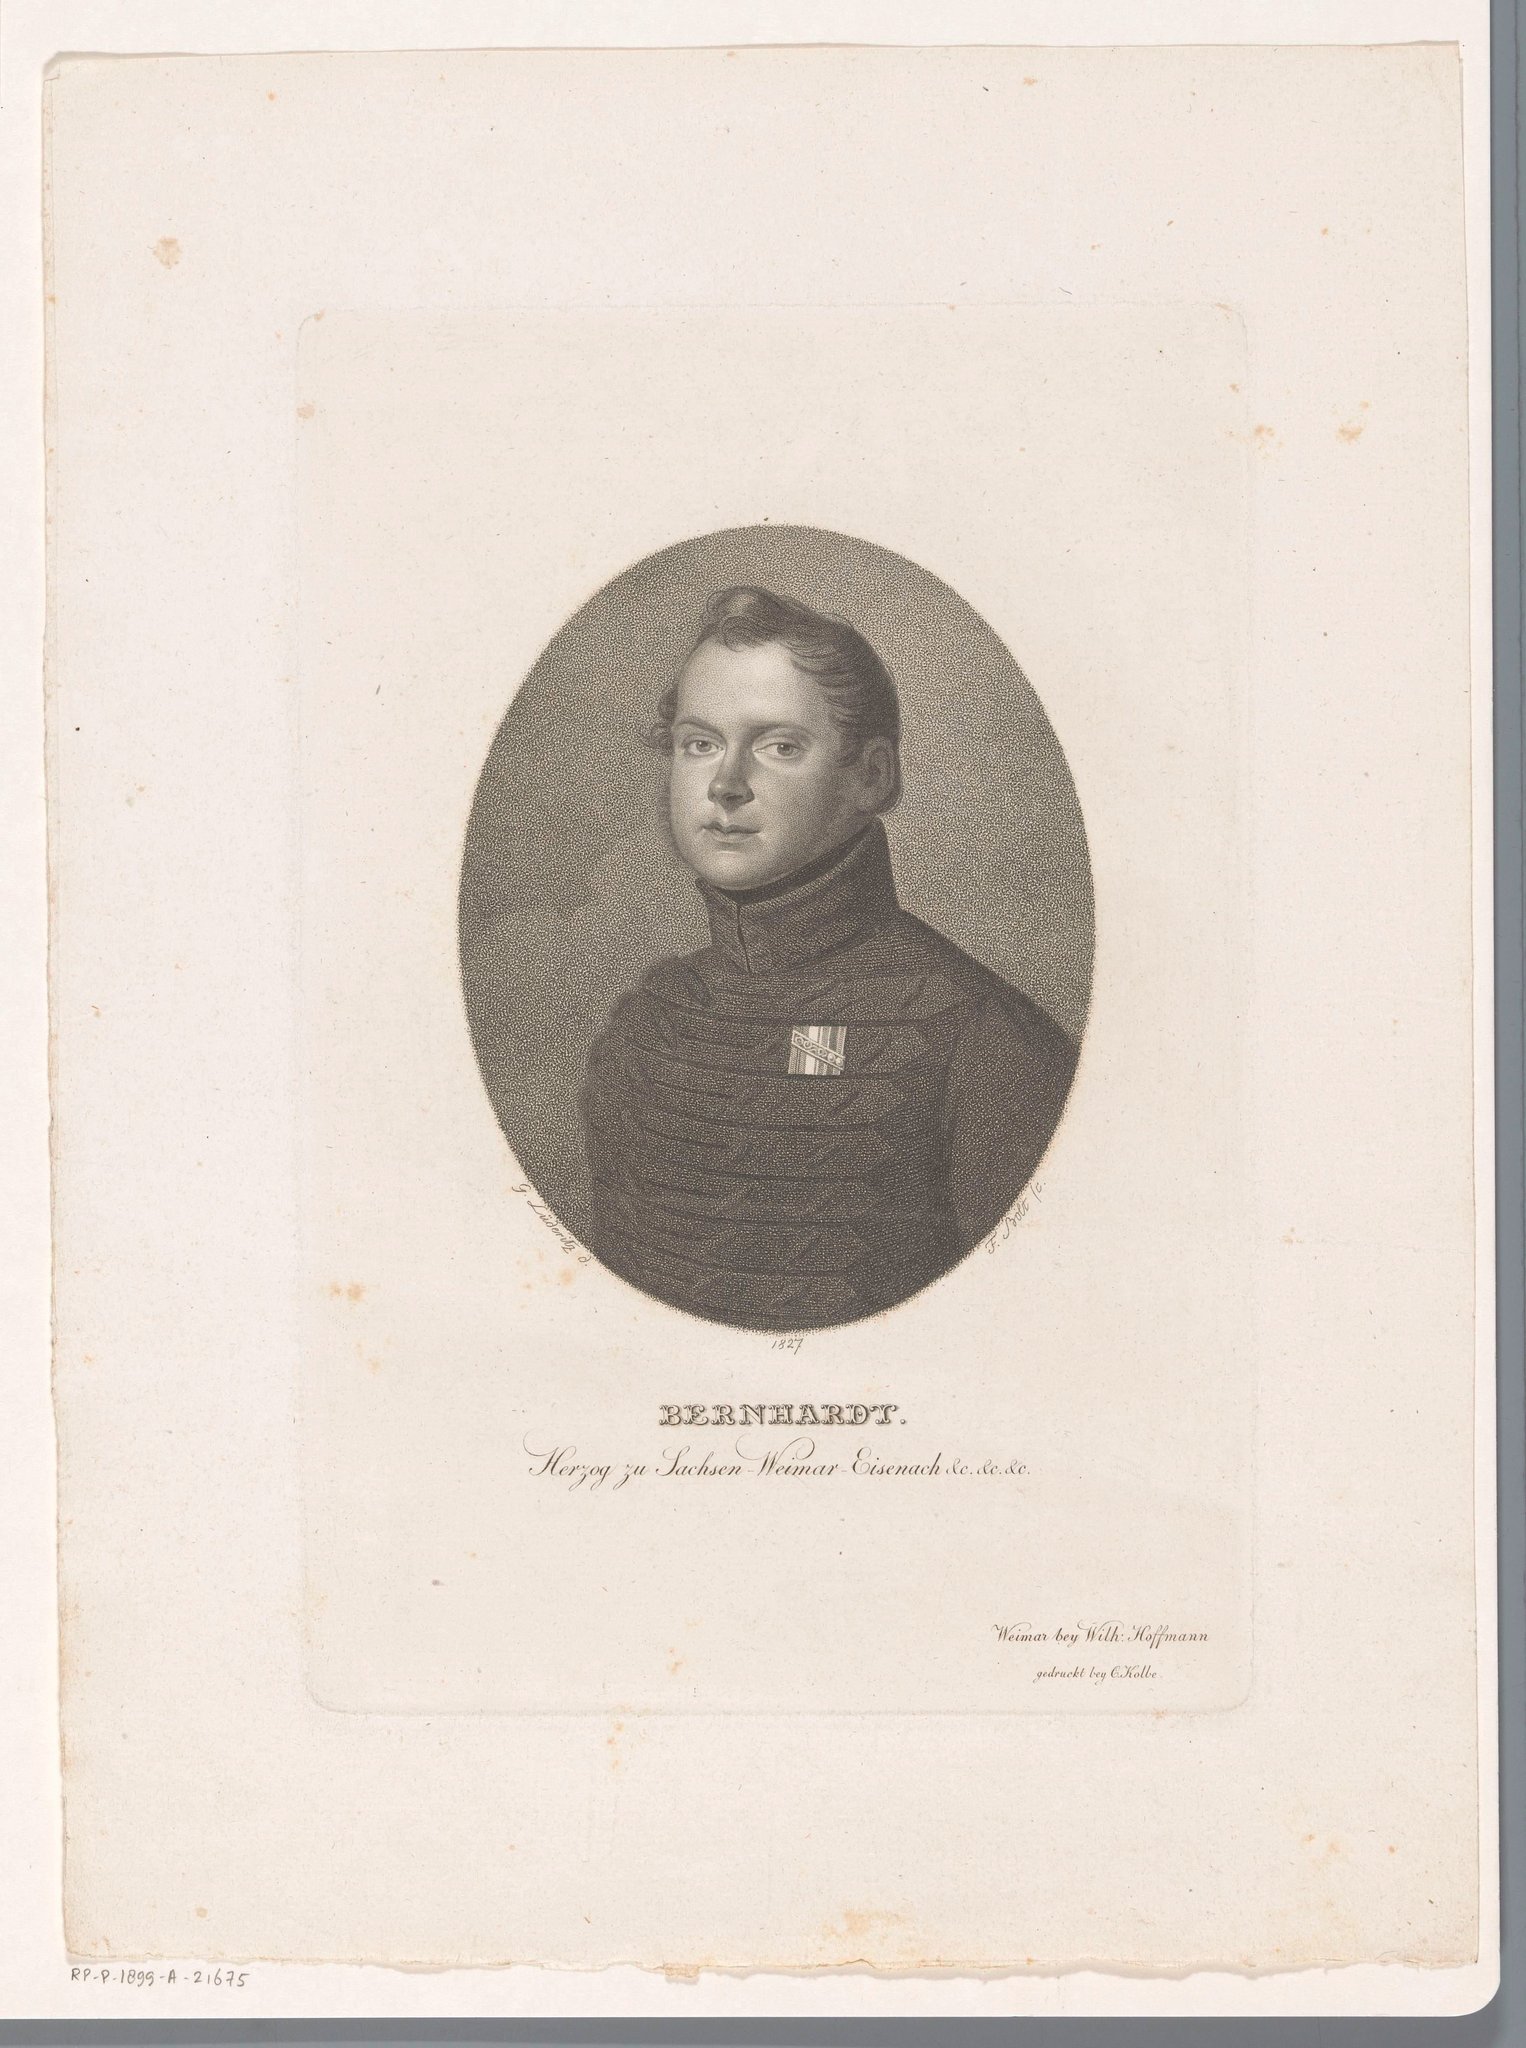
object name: print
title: Portret van Karl Bernhard von Sachsen-Weimar-Eisenach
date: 1827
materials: paper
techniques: stippling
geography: weimar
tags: karel bernhard (hertog van saksen-weimar-eisenach), historical persons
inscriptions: collector's mark: Lugt 2228